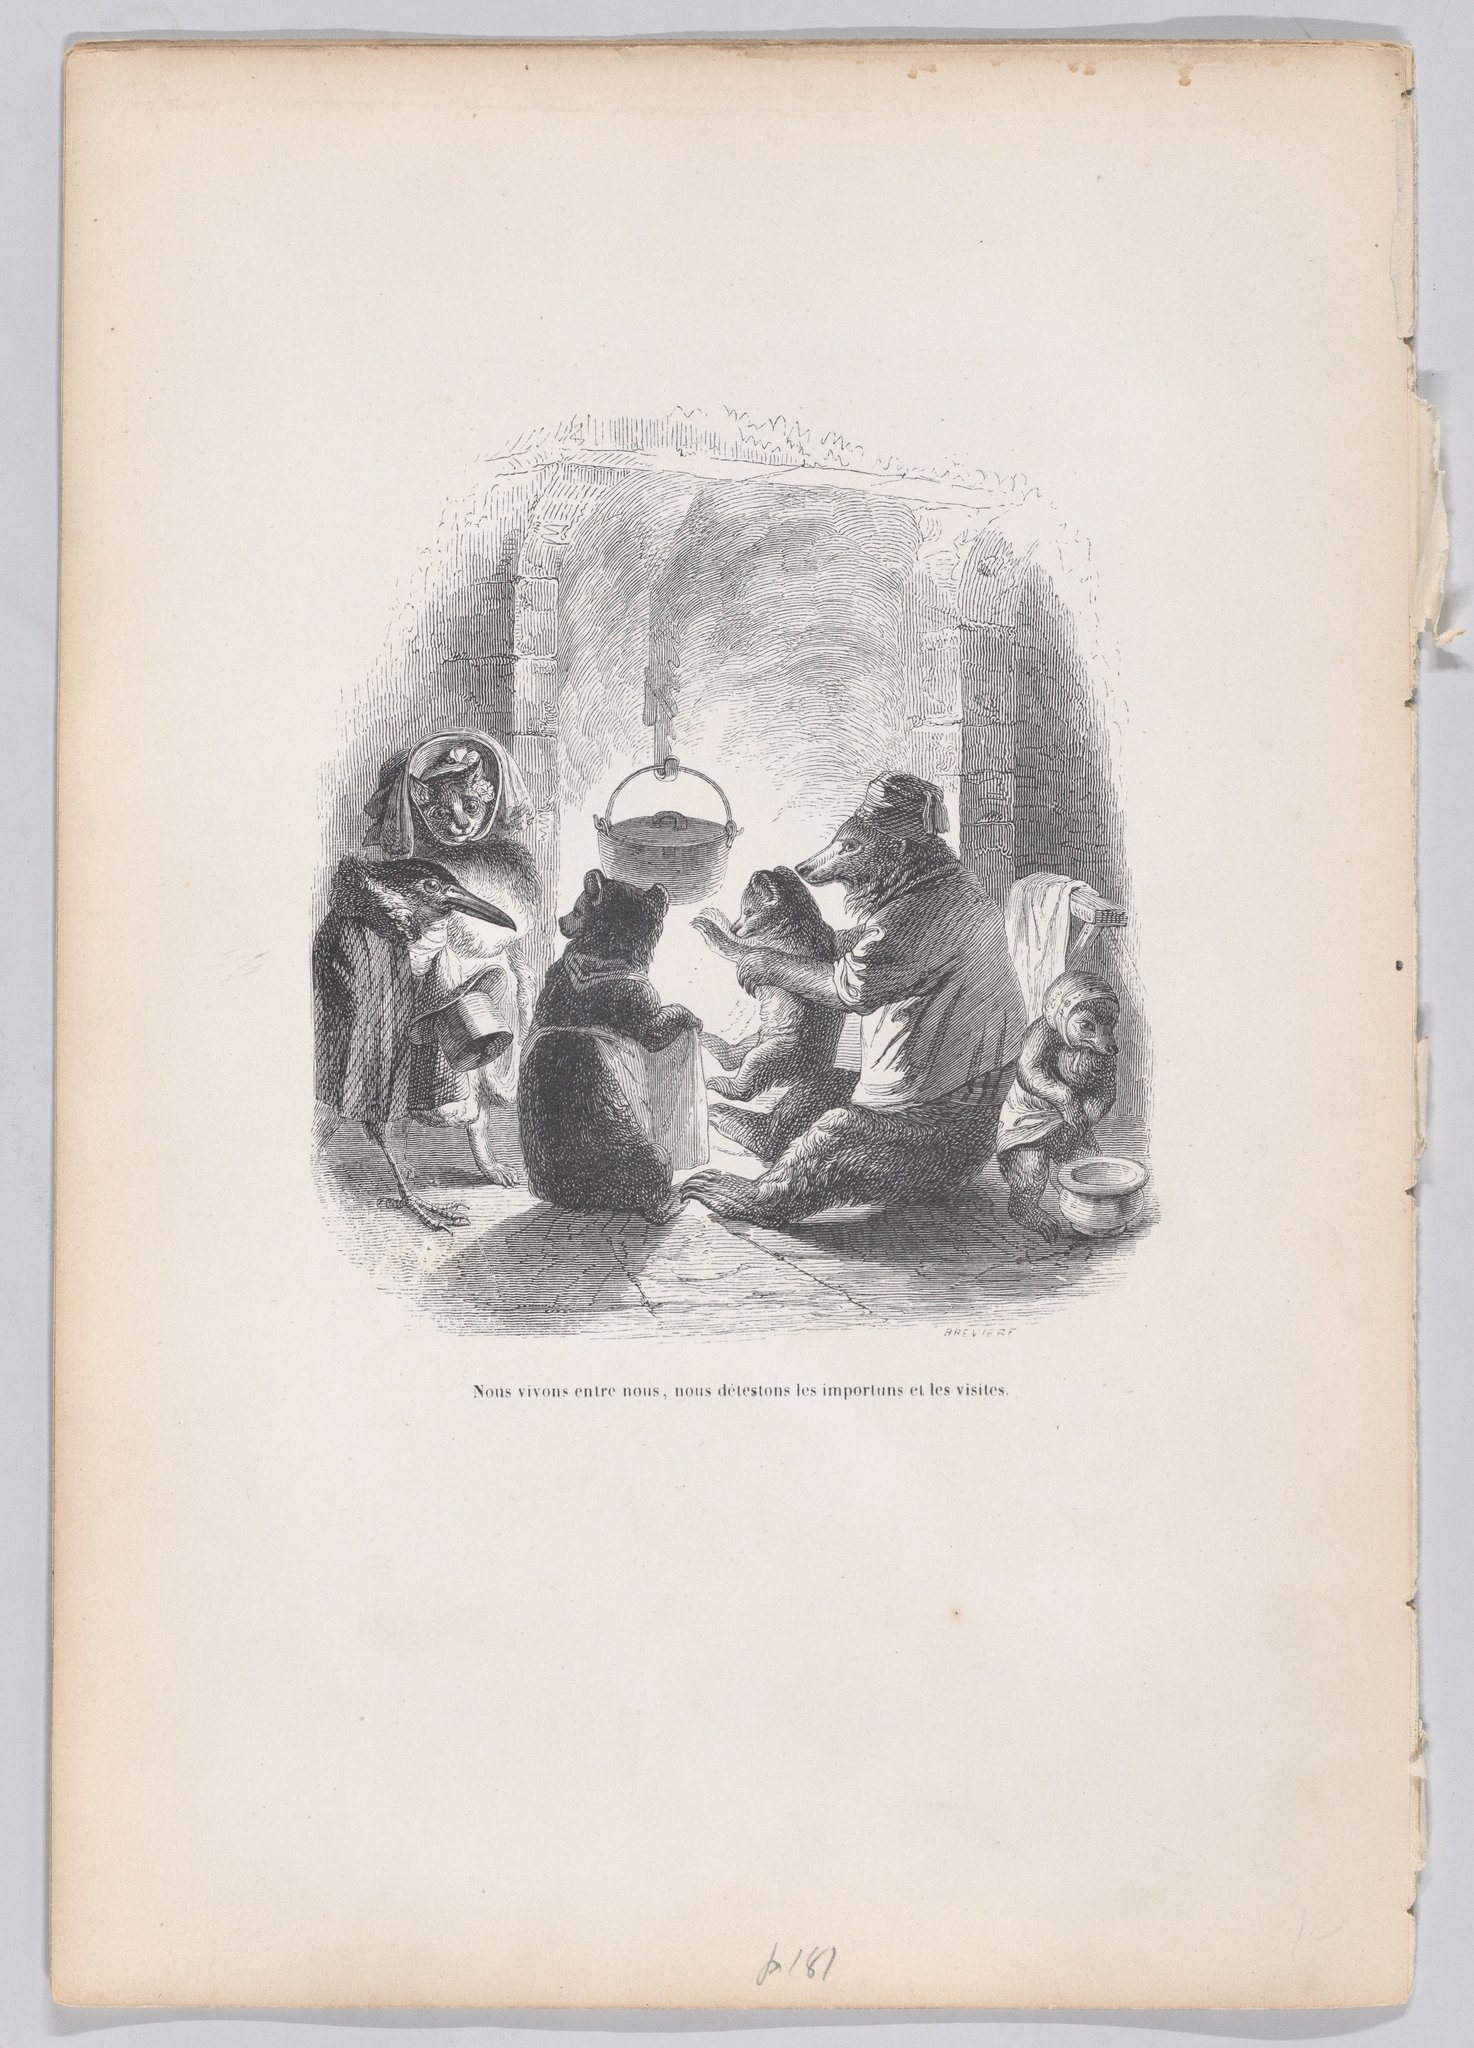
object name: print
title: We live between ourselves, we hate the nuisances and the visits, from "Scenes from the Private and Public Life of Animals"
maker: j. j. grandville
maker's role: illustrator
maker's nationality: french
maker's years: 1803-1847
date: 1837-1847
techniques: engraving